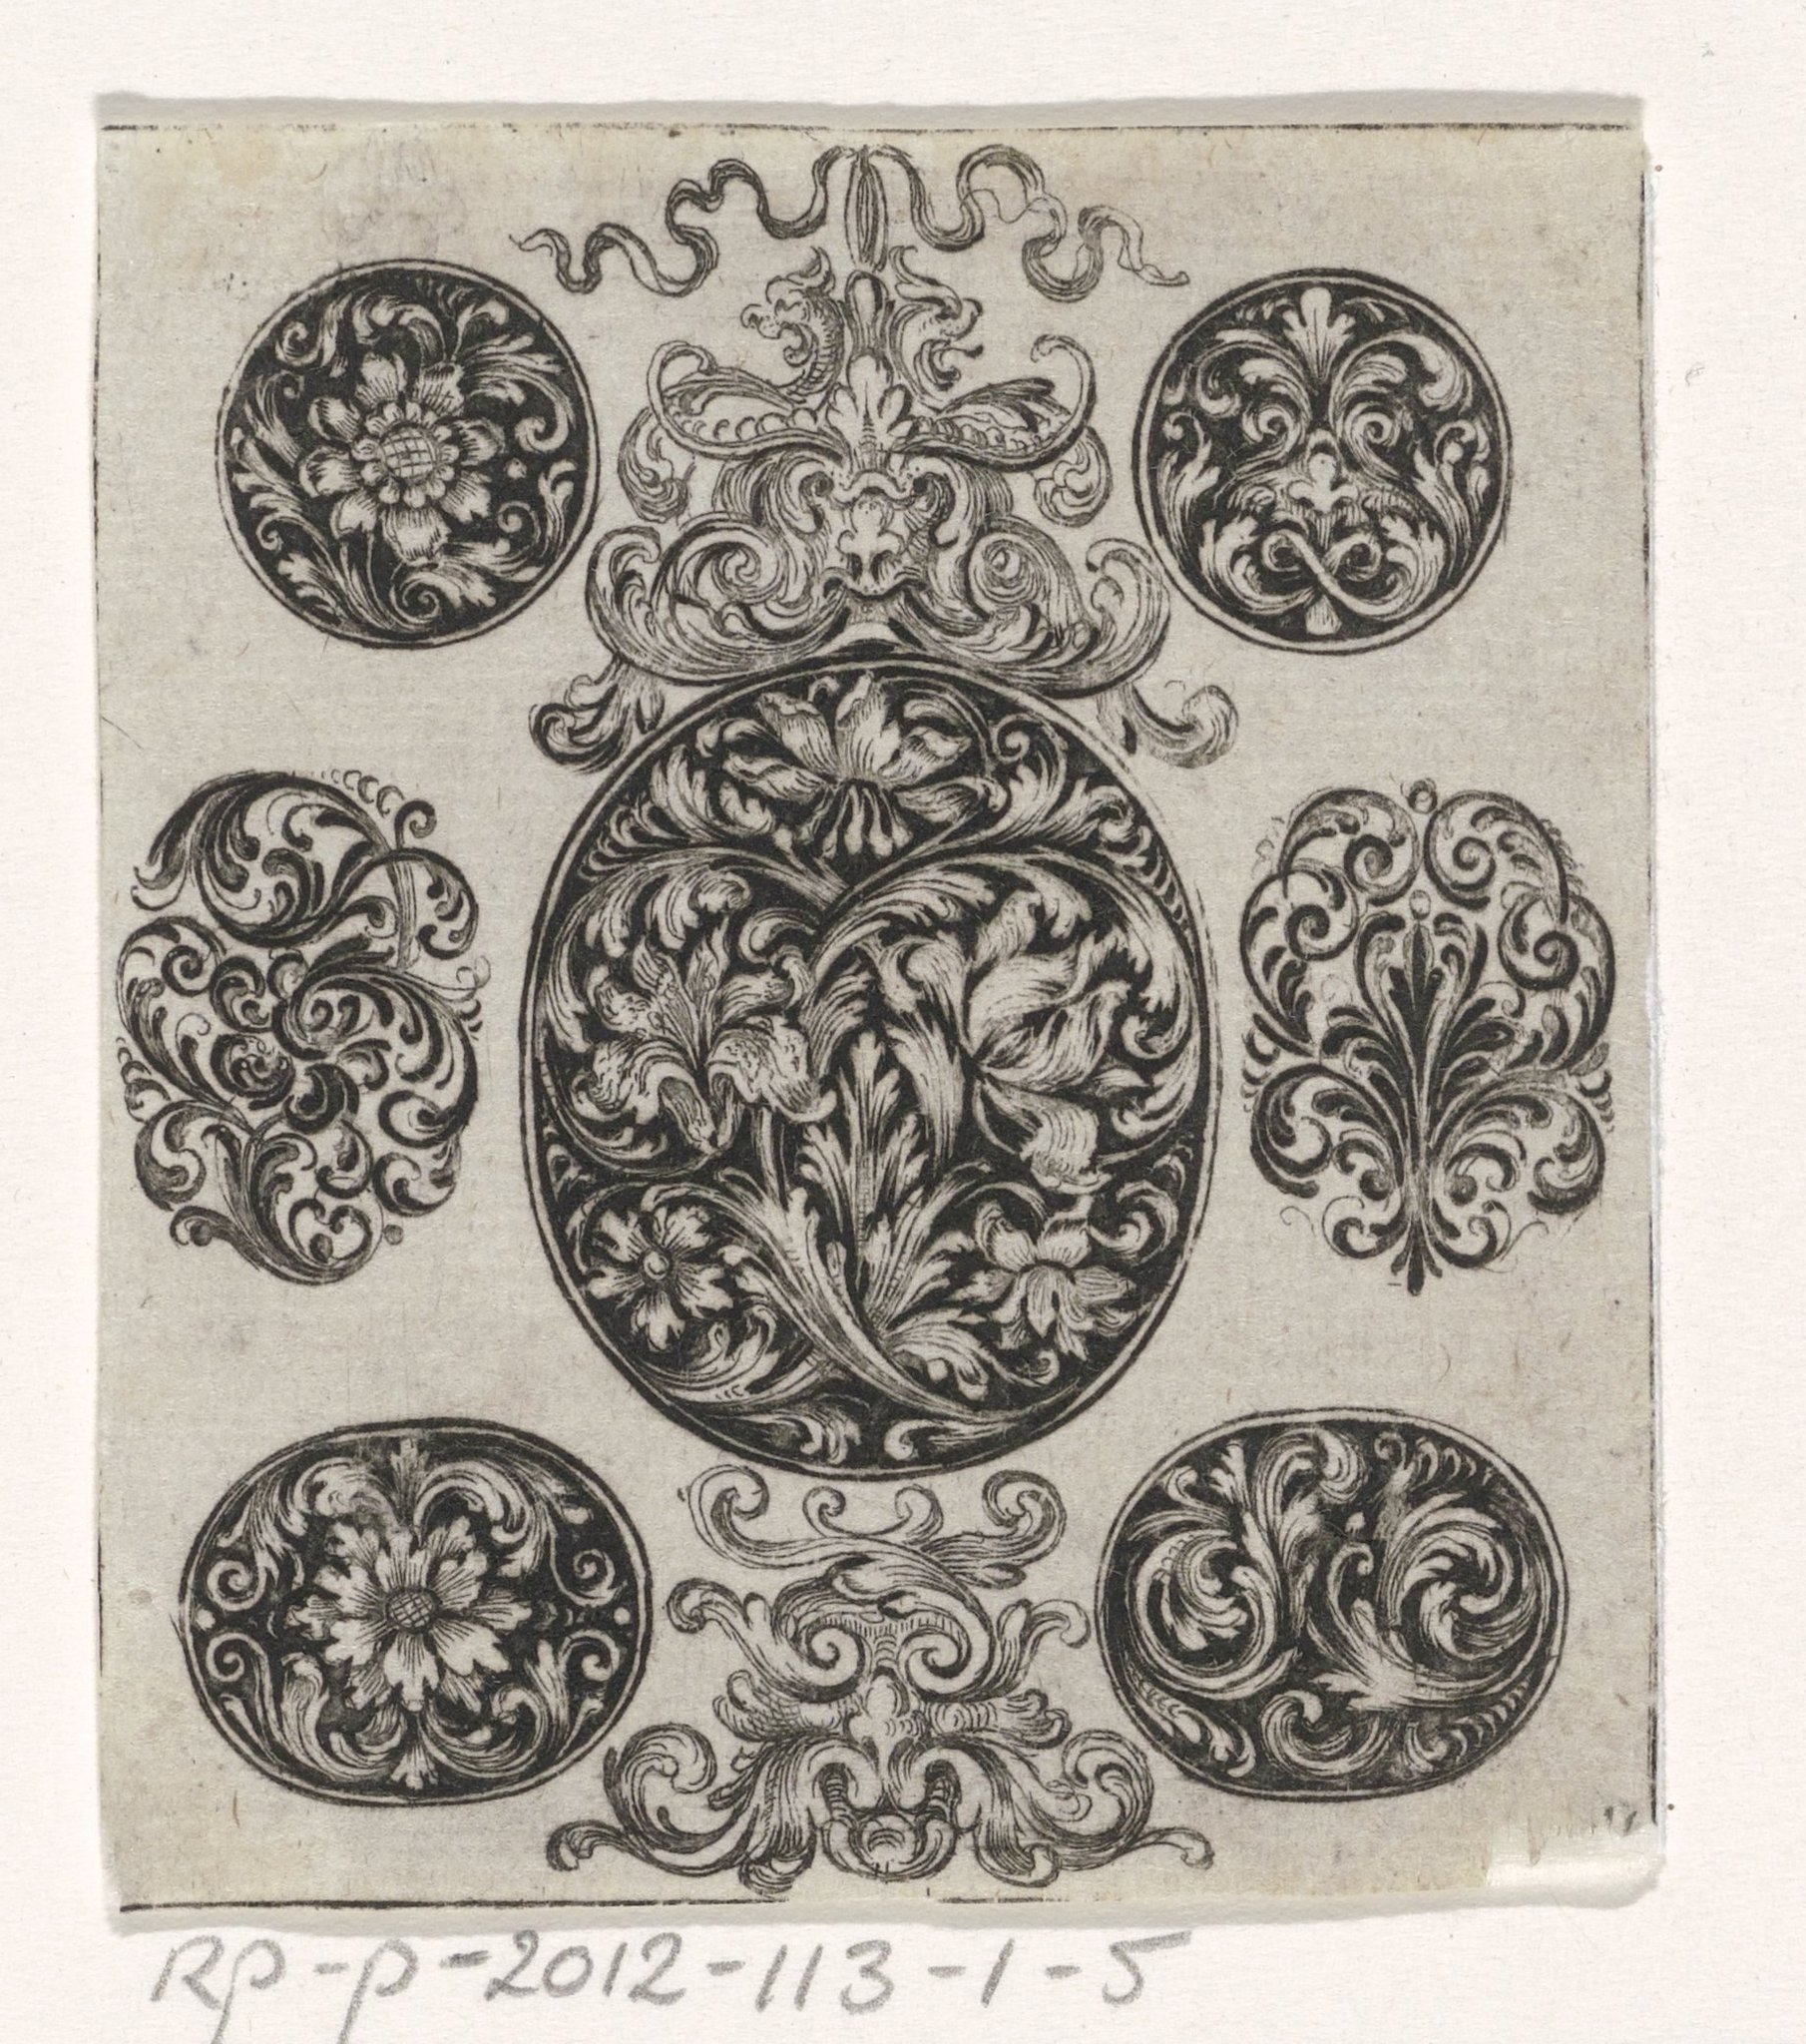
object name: ornament print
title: Serie van zes ornamenten voor goudsmeden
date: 1647-1709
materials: paper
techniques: engraving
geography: nuremberg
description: Vijf medaillons, rondom een centrale ovaal boven in de hoeken twee ronde medaillons, onder twee ovale.